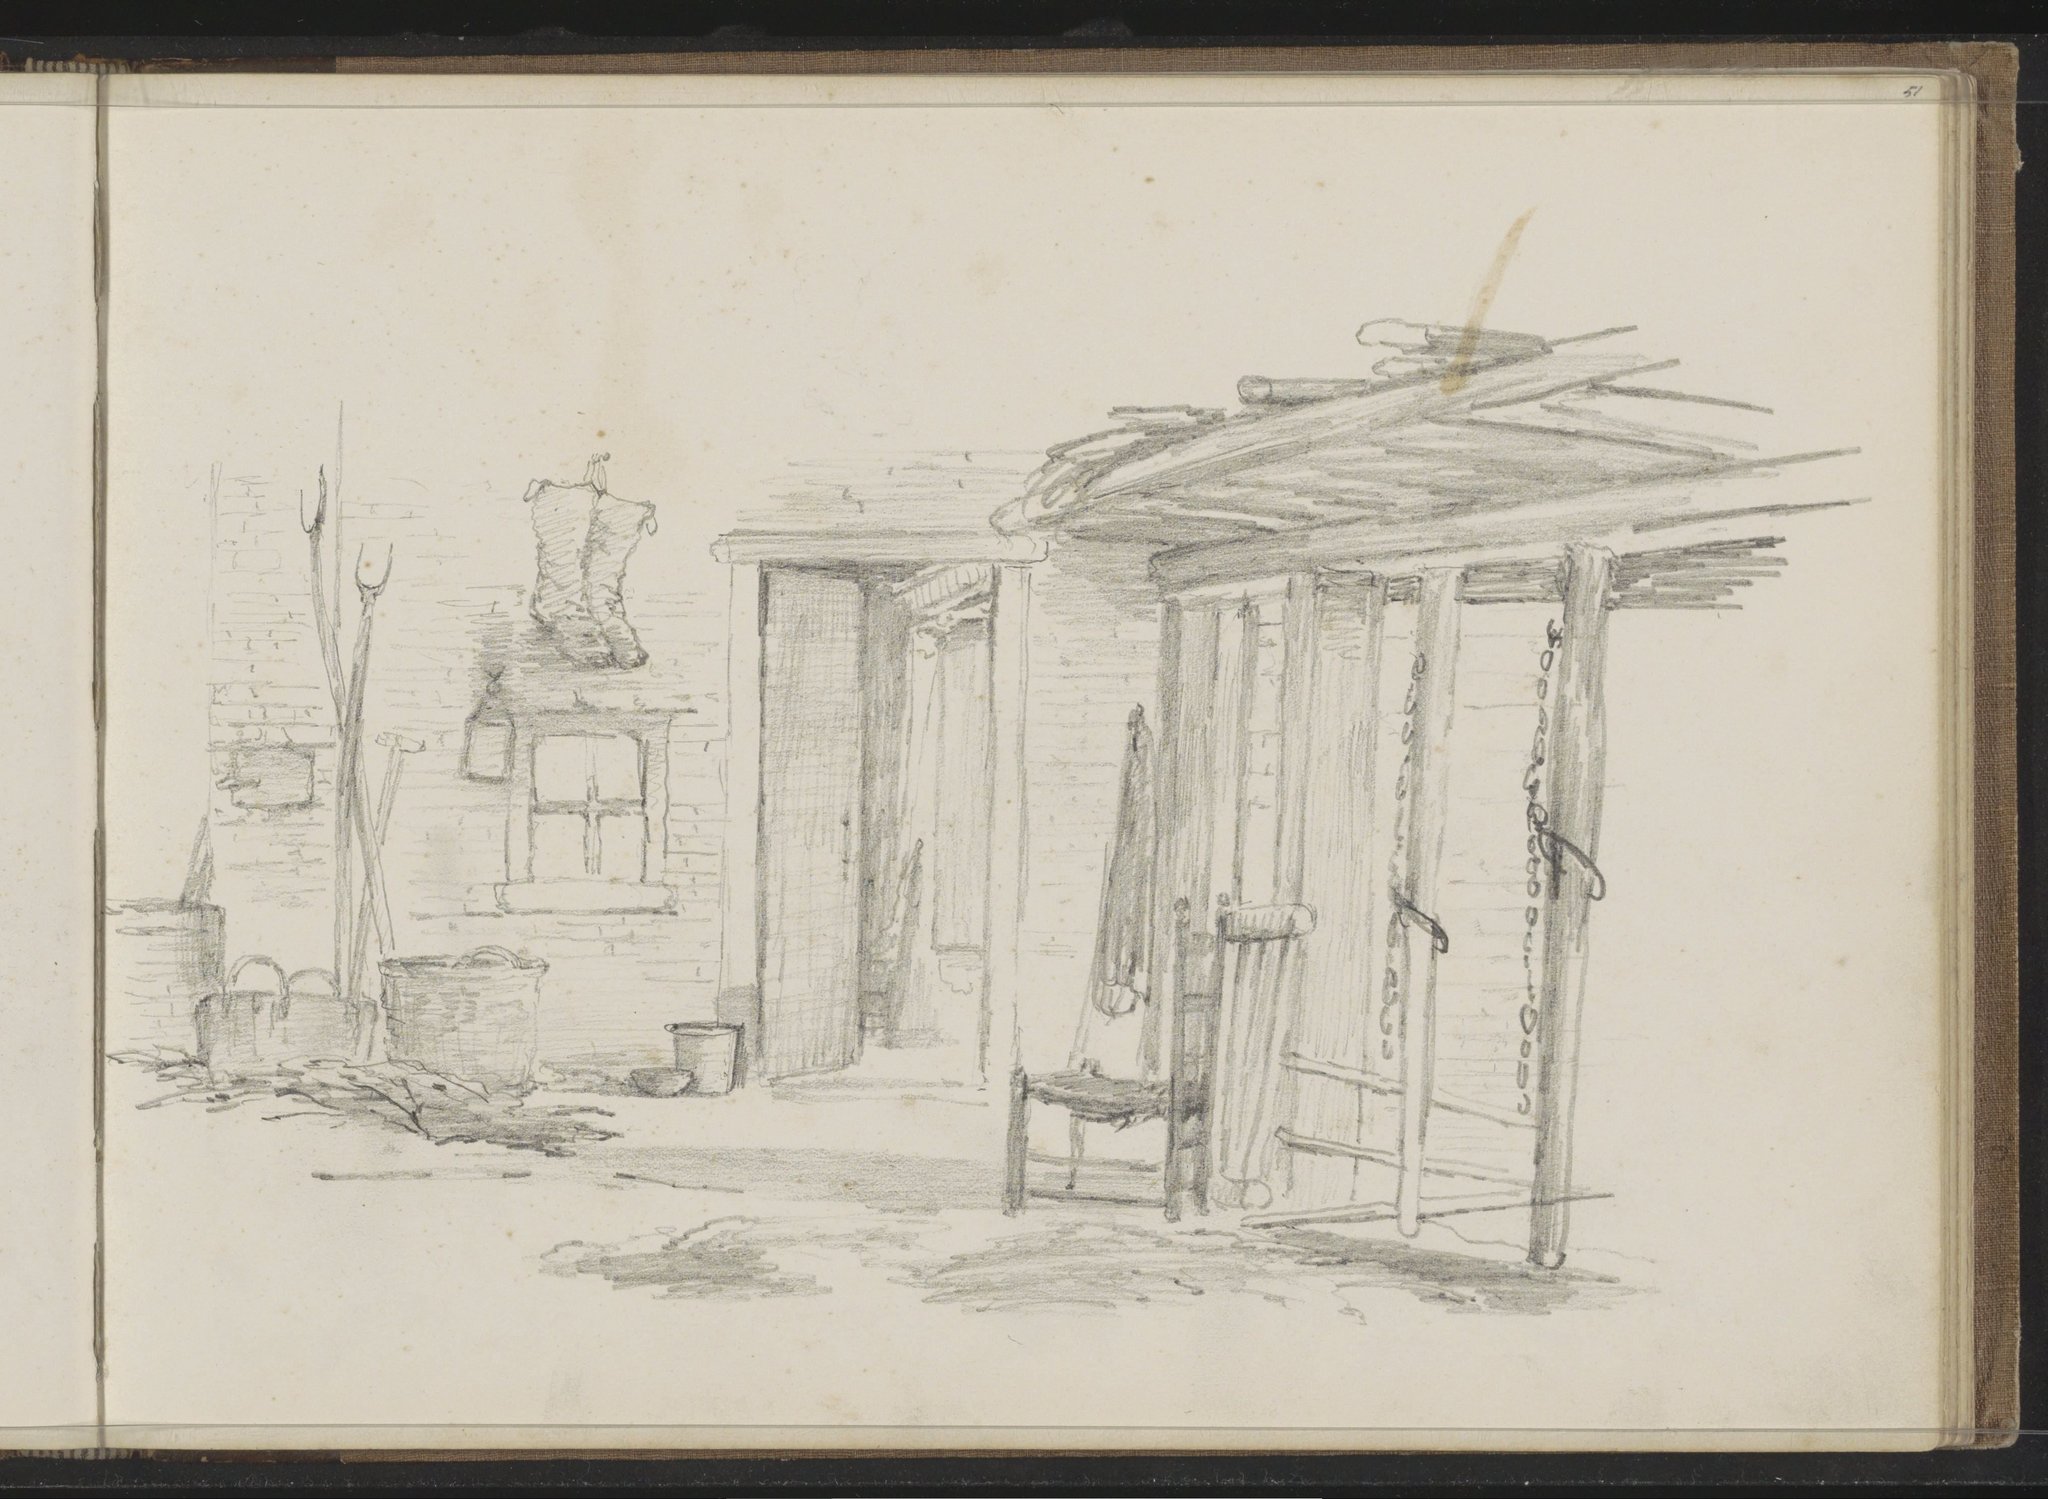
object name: sketchbook leaf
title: Achterplaats van een boerenwoning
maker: hendrik valkenburg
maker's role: draughtsman, painter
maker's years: 1826-1896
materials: paper, pencil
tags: agricultural implements: pitchfork, open door, boots, cottage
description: Gezicht op de open deur van de woning. Naast de deur hangt een paar laarzen en staan manden, emmers en hooivorken. Blad 51 recto uit een schetsboek met 77 bladen.